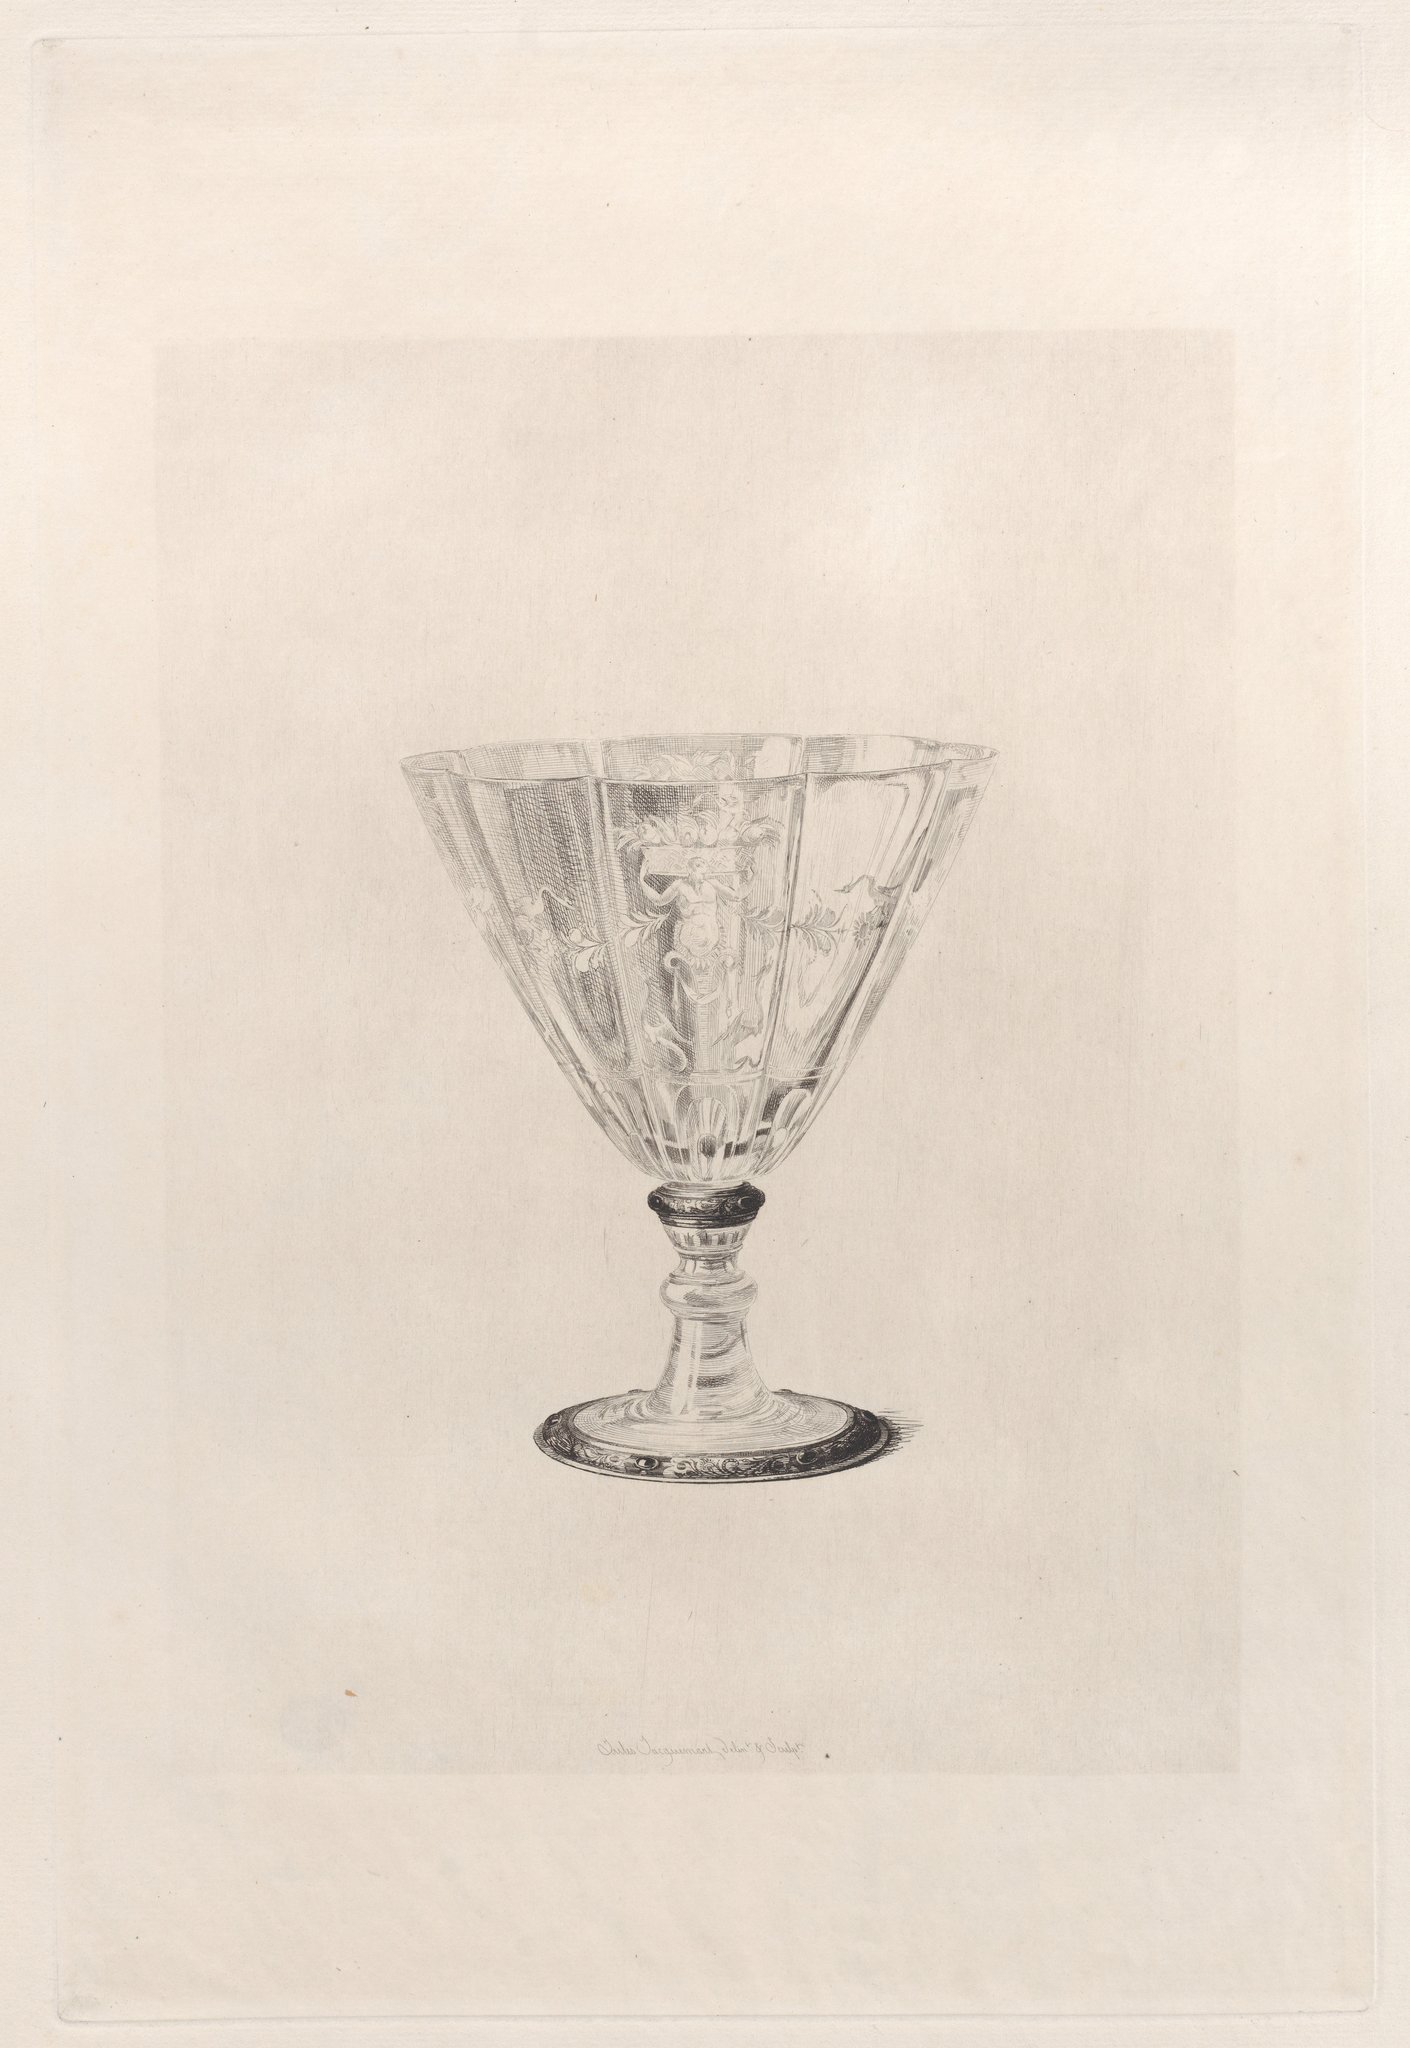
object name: print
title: Crystal Drinking Glass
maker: jules-ferdinand jacquemart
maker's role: artist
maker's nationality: french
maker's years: 1837-1880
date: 1868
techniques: etching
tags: drinking glasses